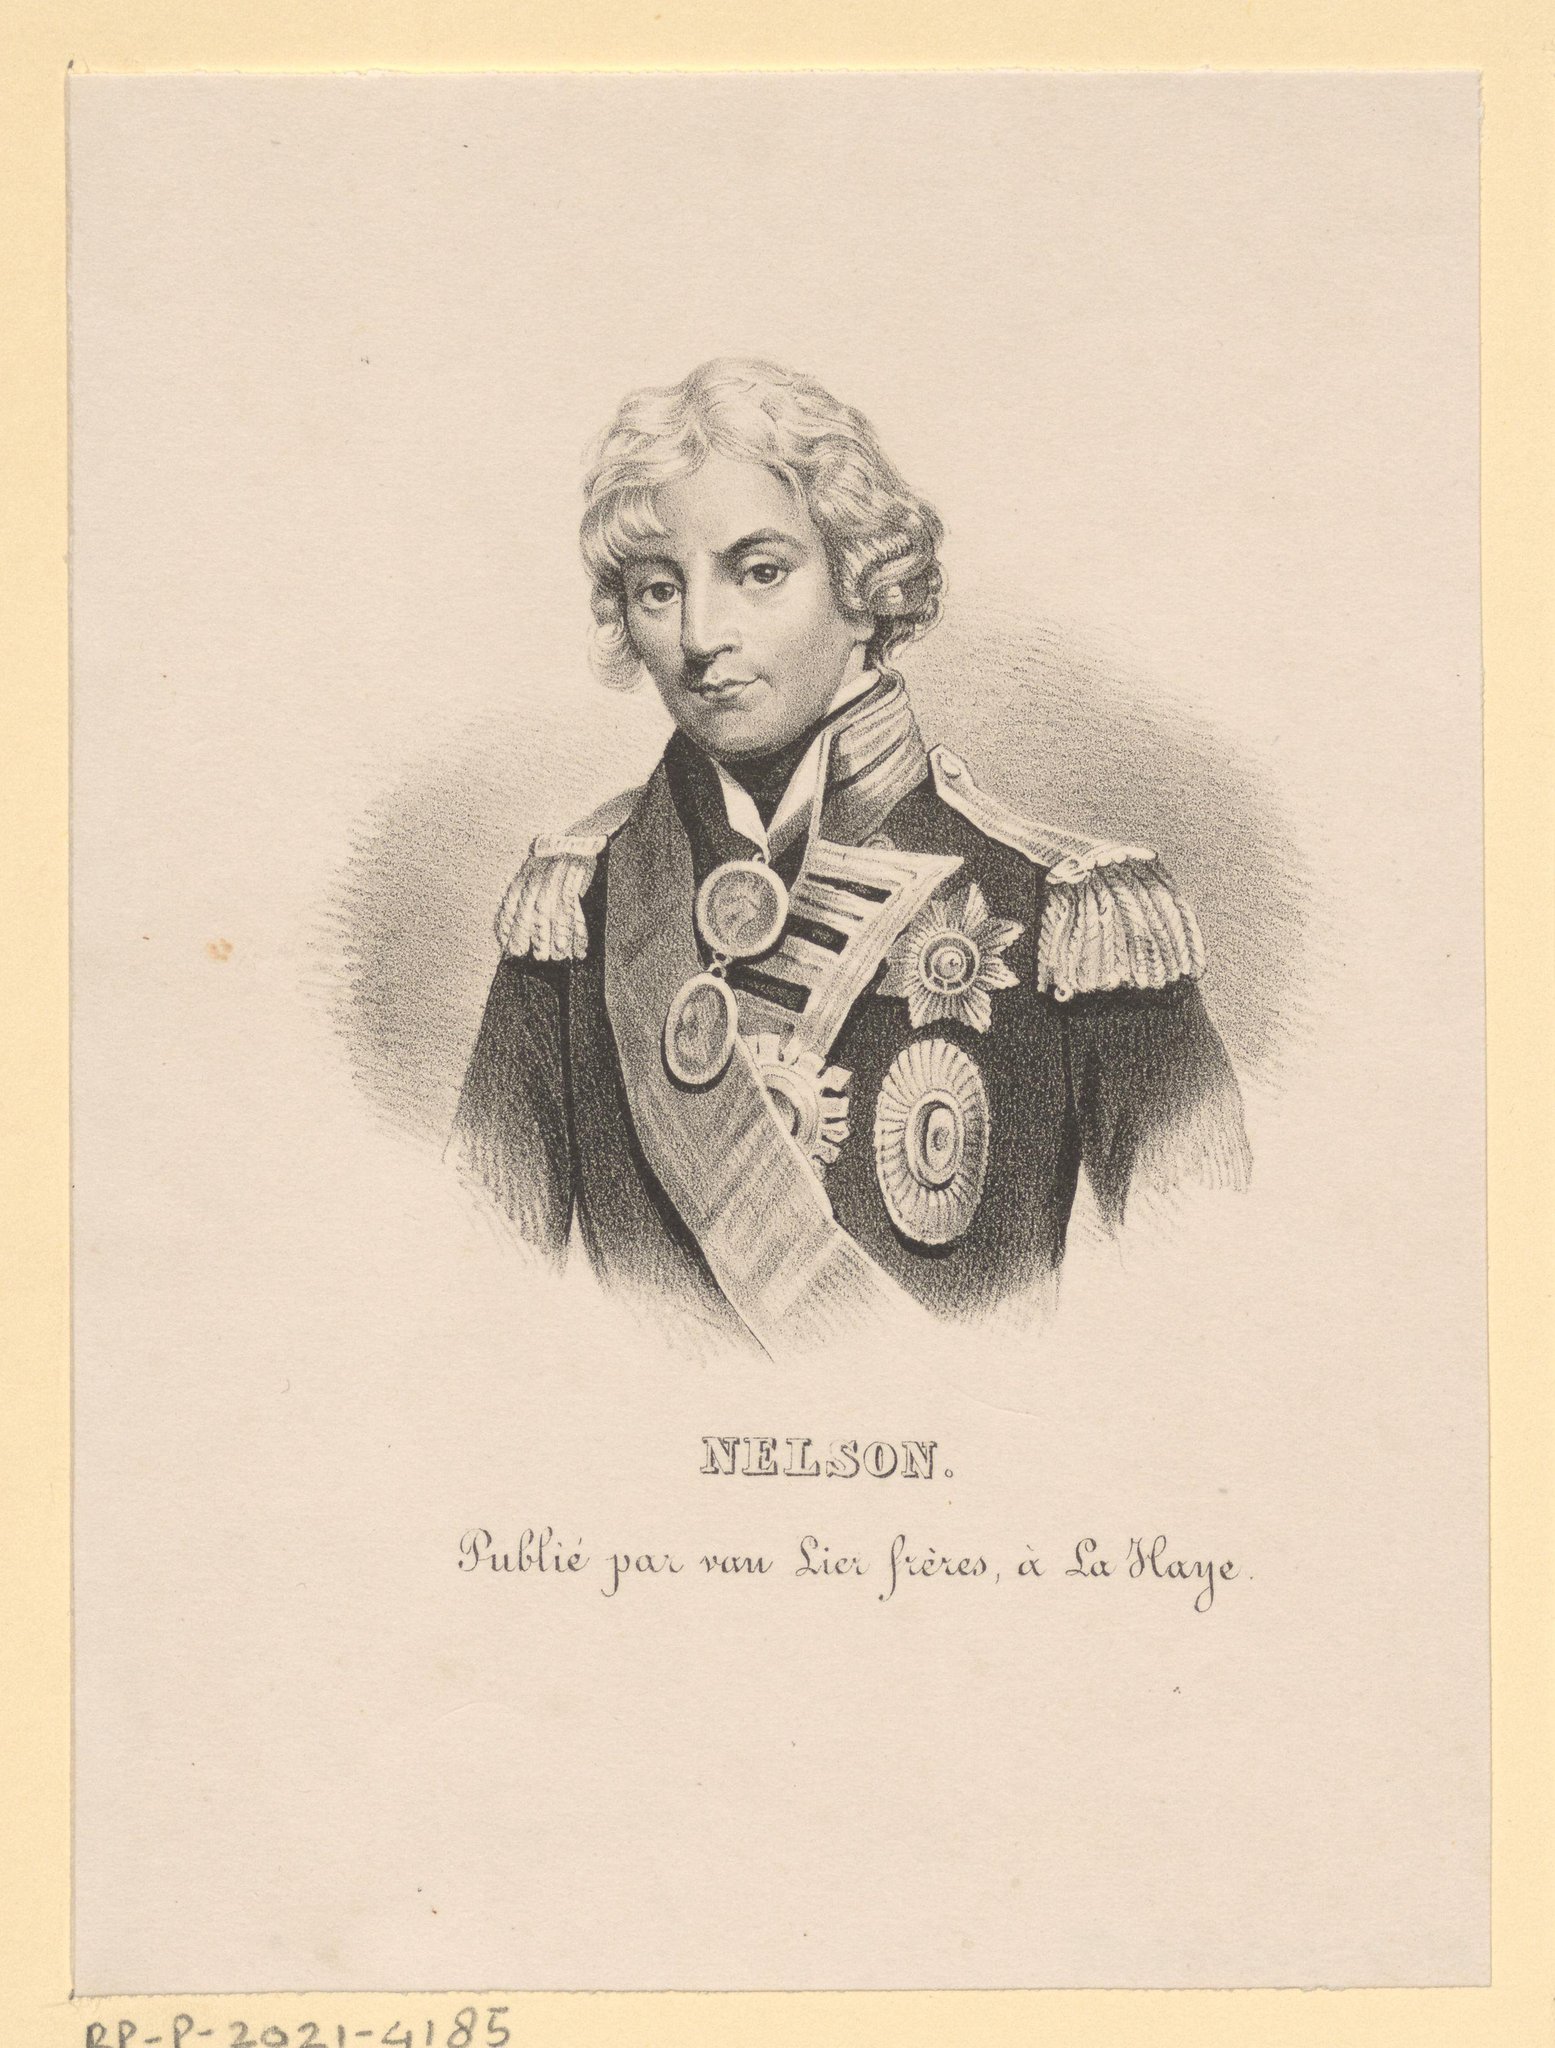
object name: print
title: Portret van Horatio Nelson, hertog van Bronte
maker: Anonymous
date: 1833-1846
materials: paper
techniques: lithograph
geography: the hague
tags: horatio nelson (hertog van bronte), historical persons, commander-in-chief, admiral